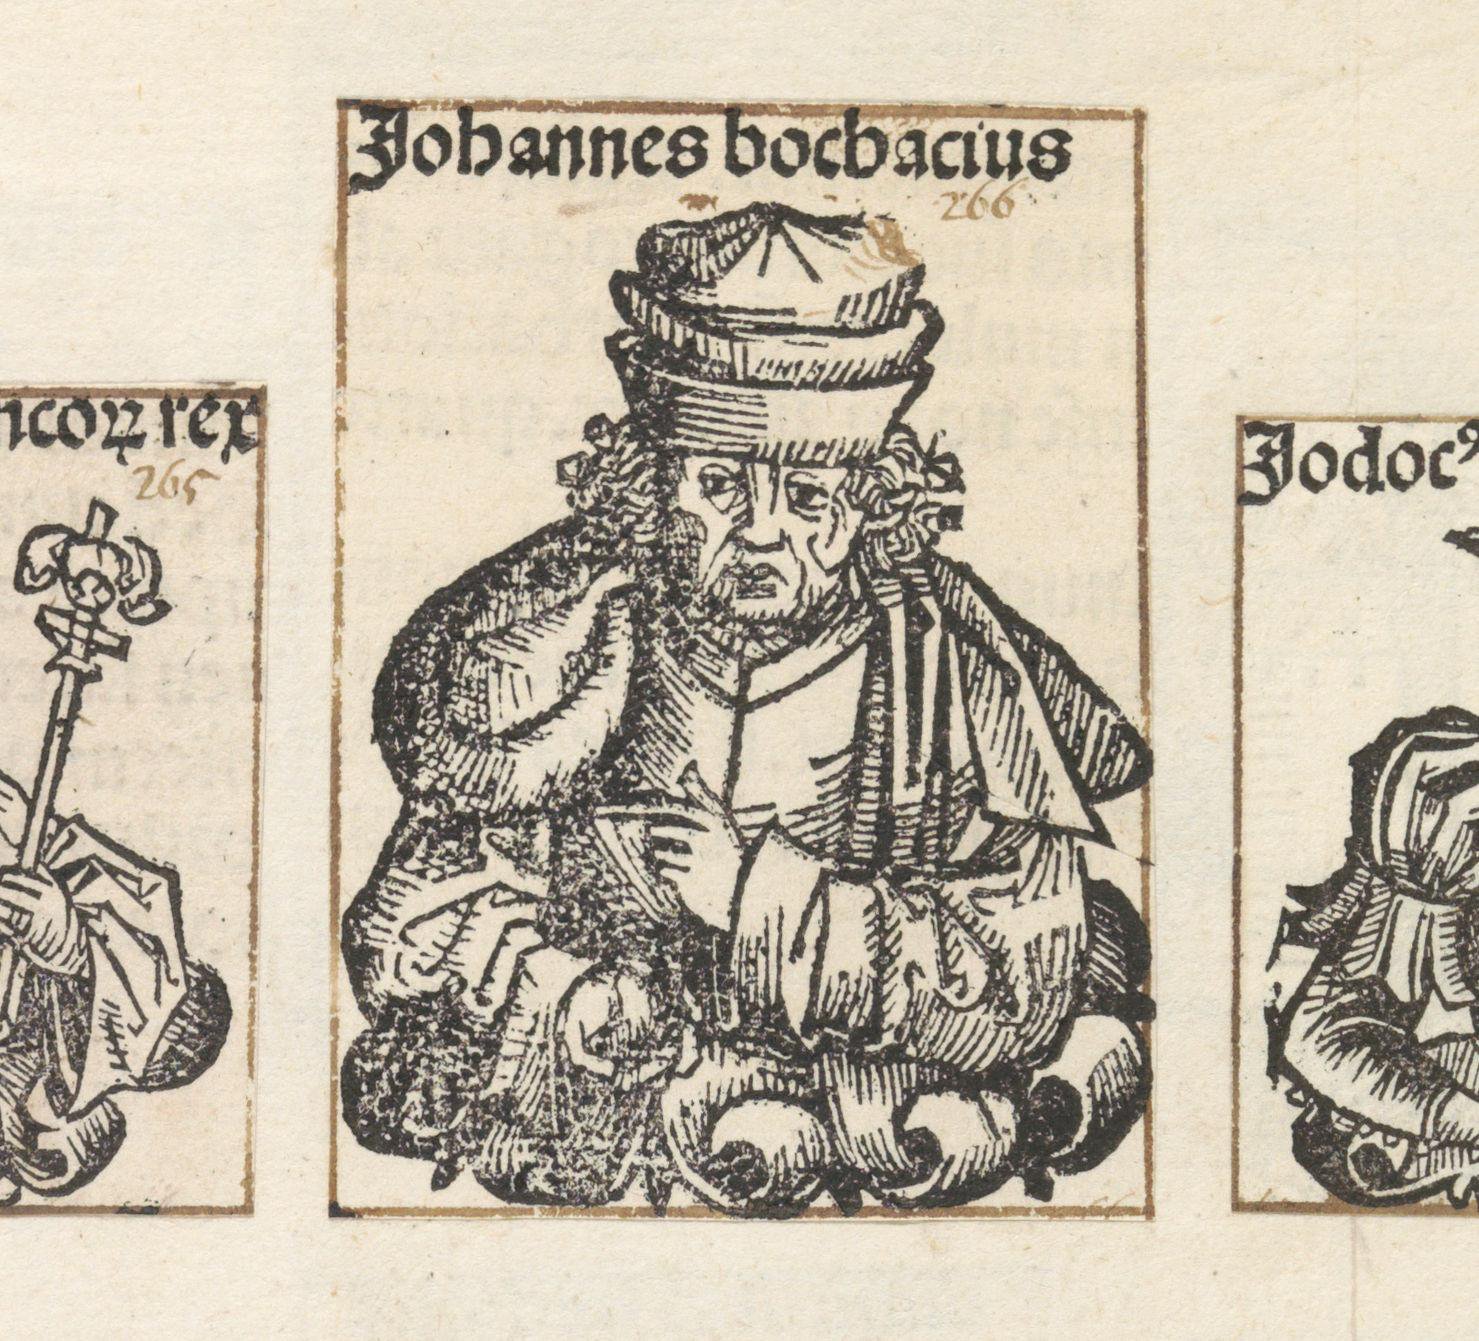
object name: book illustration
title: Giovanni Boccaccio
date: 1493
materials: paper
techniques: letterpress printing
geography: nuremberg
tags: giovanni boccaccio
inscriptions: inscription: ‘266’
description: De houtsnede wordt herhaaldelijk gebruikt als boekillustratie in de Liber Chronicarum (of Neurenbergkroniek) van Hartmann Schedel, verschenen in het Latijn en Duits in 1493. Zie de Latijnse uitgave, folio 232r.